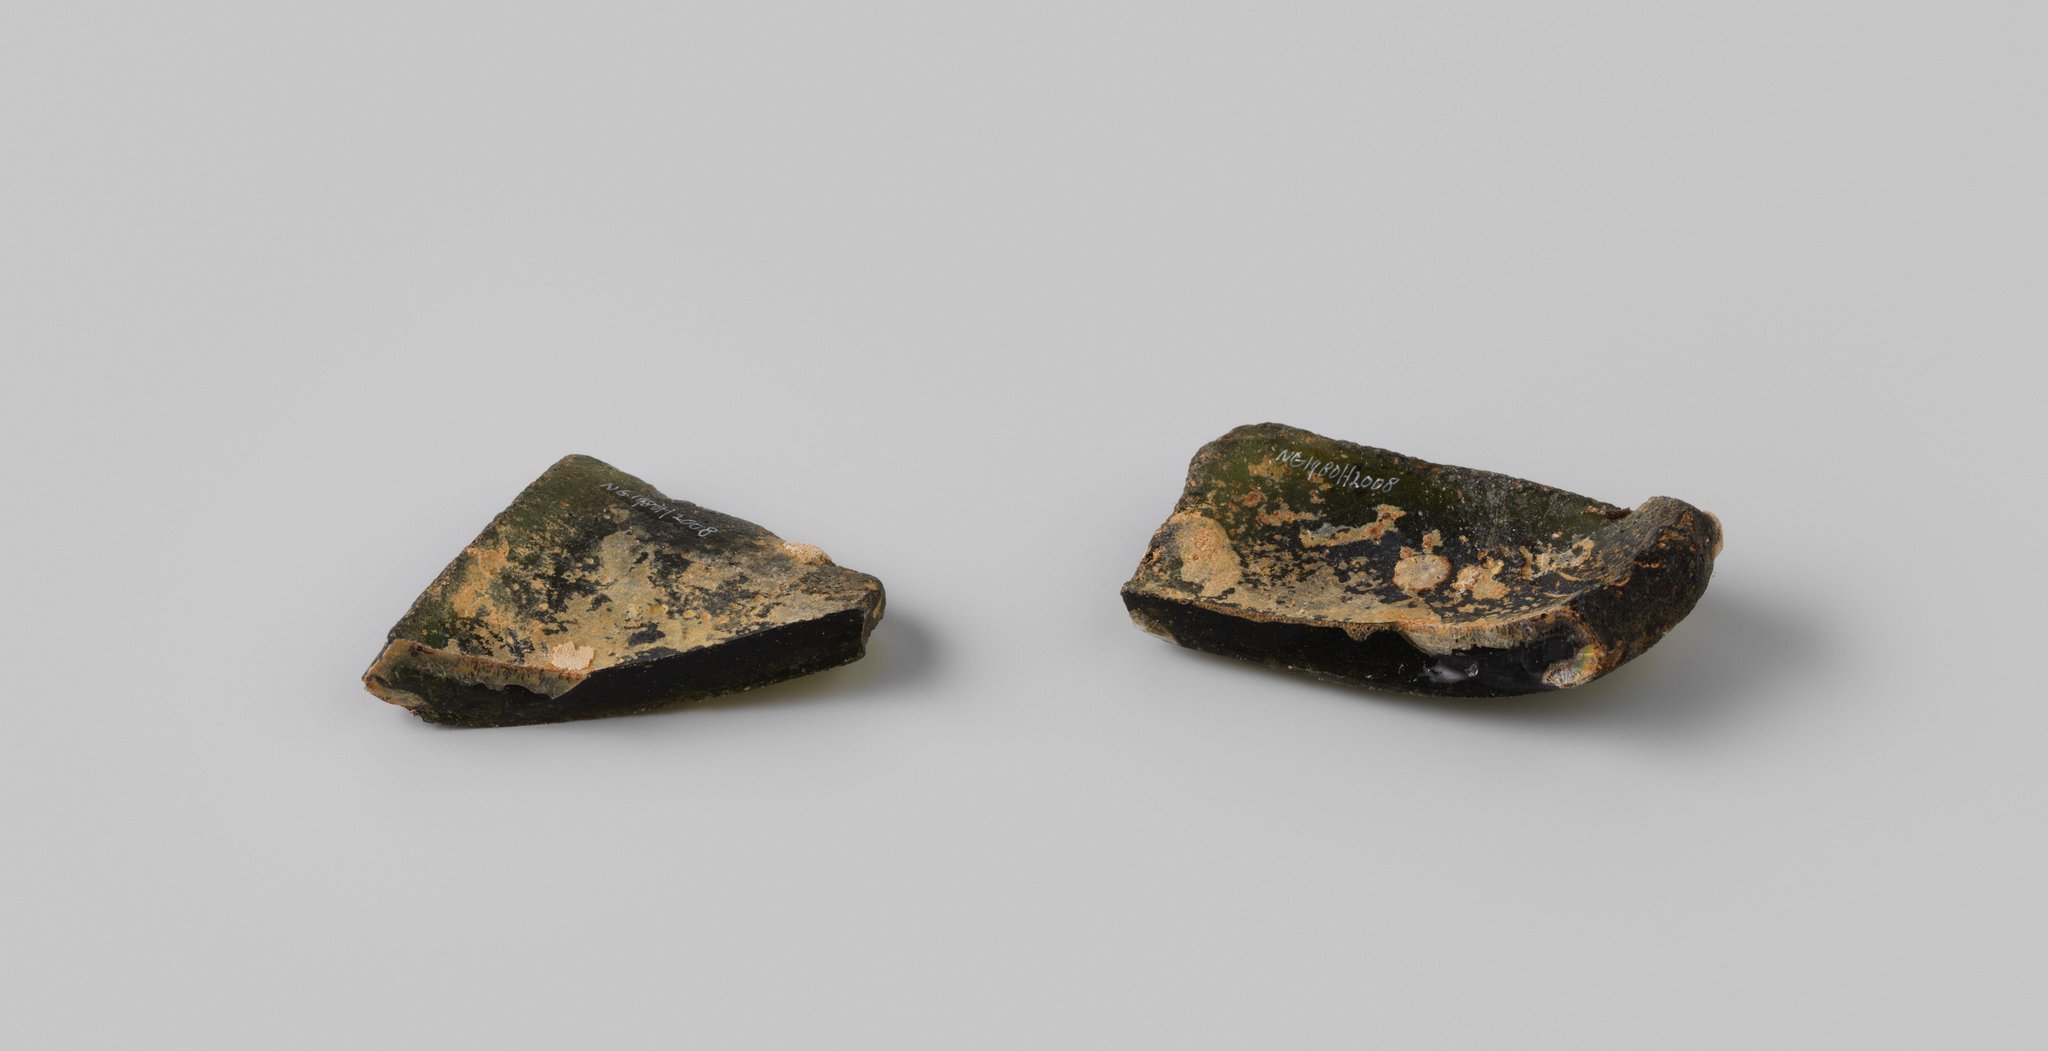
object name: sherd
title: Scherven van wijnflessen uit het wrak van de Oost-Indiëvaarder Hollandia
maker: Anonymous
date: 1700-1743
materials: glass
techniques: green glass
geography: netherlands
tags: verenigde oostindische compagnie, hollandia (schip), annet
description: Onion-shaped bottle or bottle with vertical side, base, fragm, tcs-kick-up. Continental production.